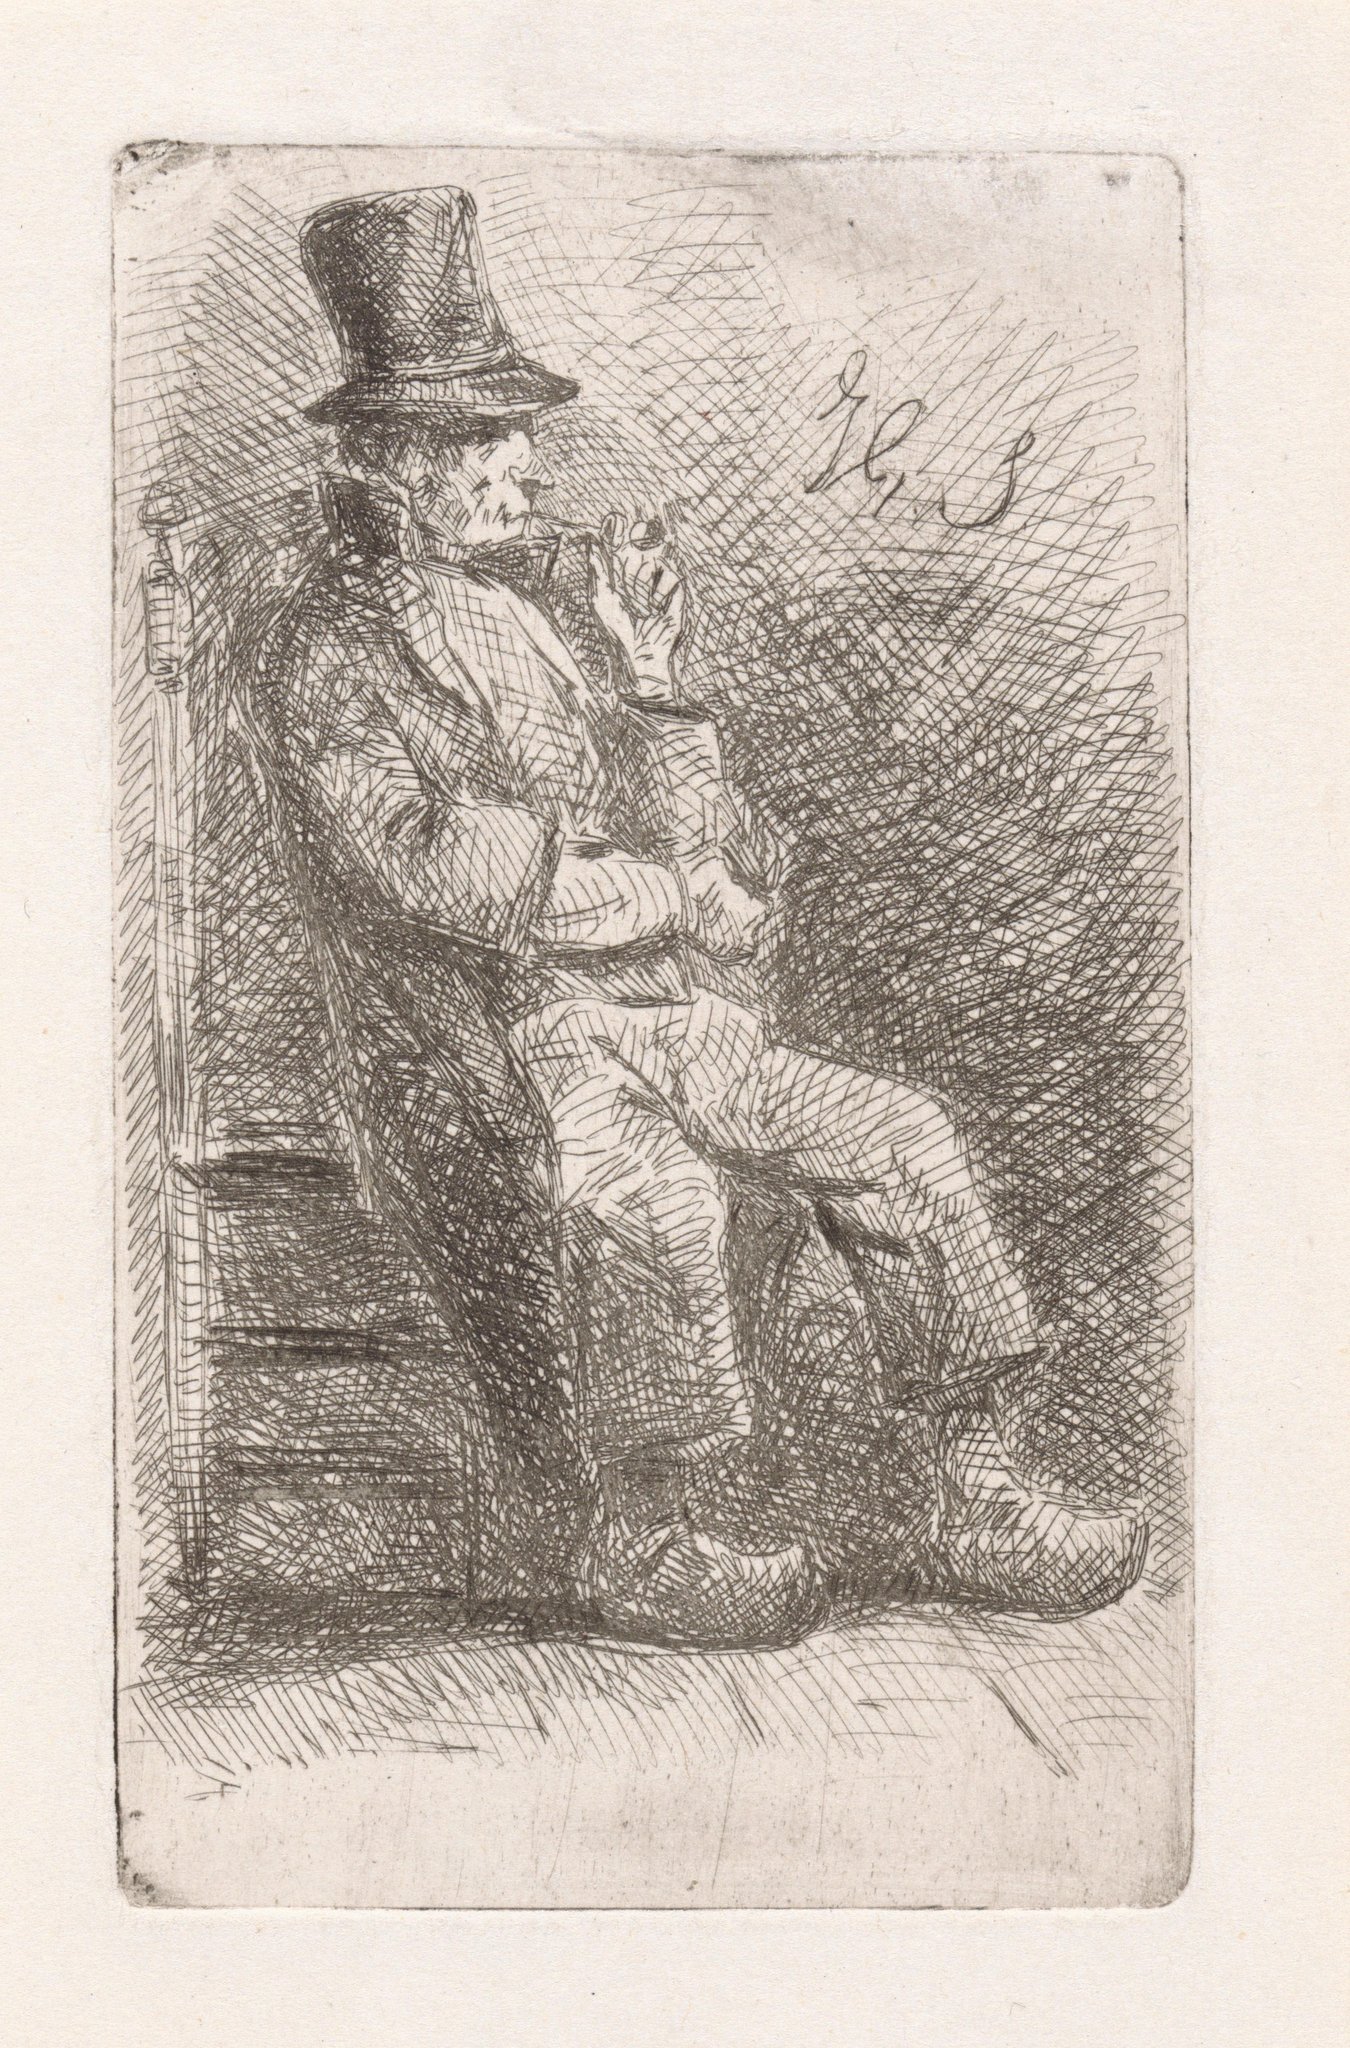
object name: print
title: Pijp rokende man met hoge hoed op een stoel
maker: jan gerard smits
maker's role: draughtsman, print maker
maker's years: 1823-1910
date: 1838-1910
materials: paper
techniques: etching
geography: the hague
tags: pipe ~ tobacco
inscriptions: collector's mark: Lugt 2228